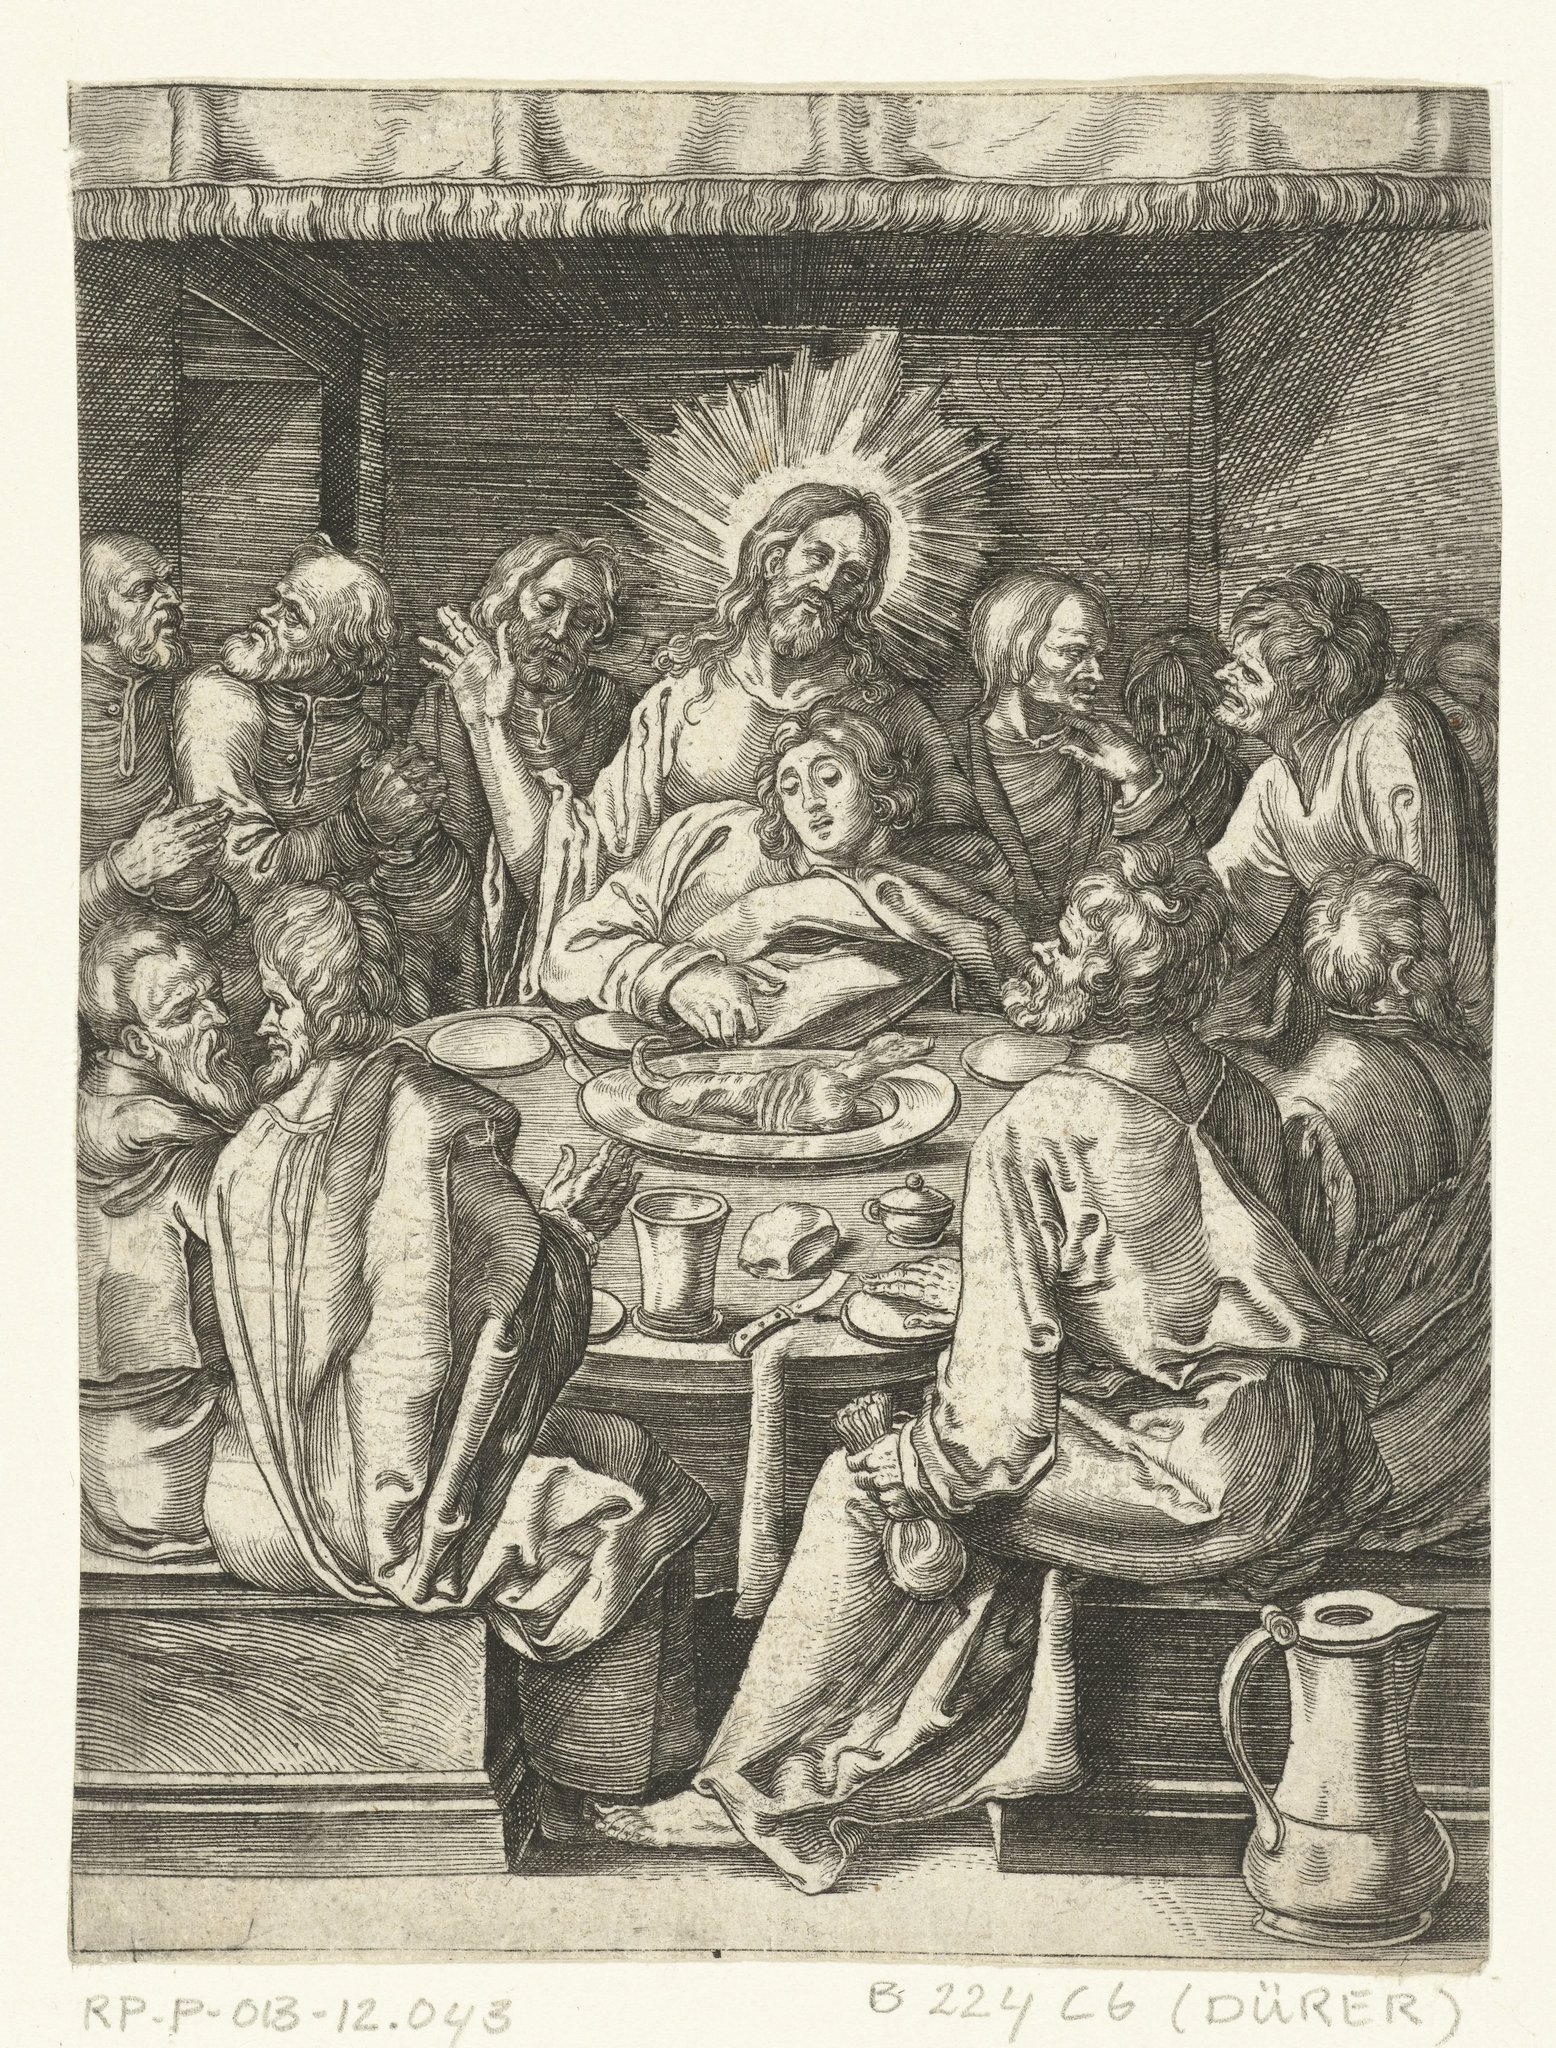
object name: print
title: Passie van Christus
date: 1510-1699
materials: paper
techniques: engraving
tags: last supper (in general) (matthew 26:21-35; mark 14:18-31; luke 22:3, 22:15-23; john 13:21-38)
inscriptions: collector's mark: Lugt 12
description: Prent naar houtsnede van Albrecht Dürer uit een serie van zevenendertig prenten met als onderwerp het levensverhaal van Christus, bekend als Passie van Christus. Illustratie gebruikt voor: Passio Christi ab Alberto Durer Nurenburgensi effigiata, Abraham van Waesberge (uitgever).